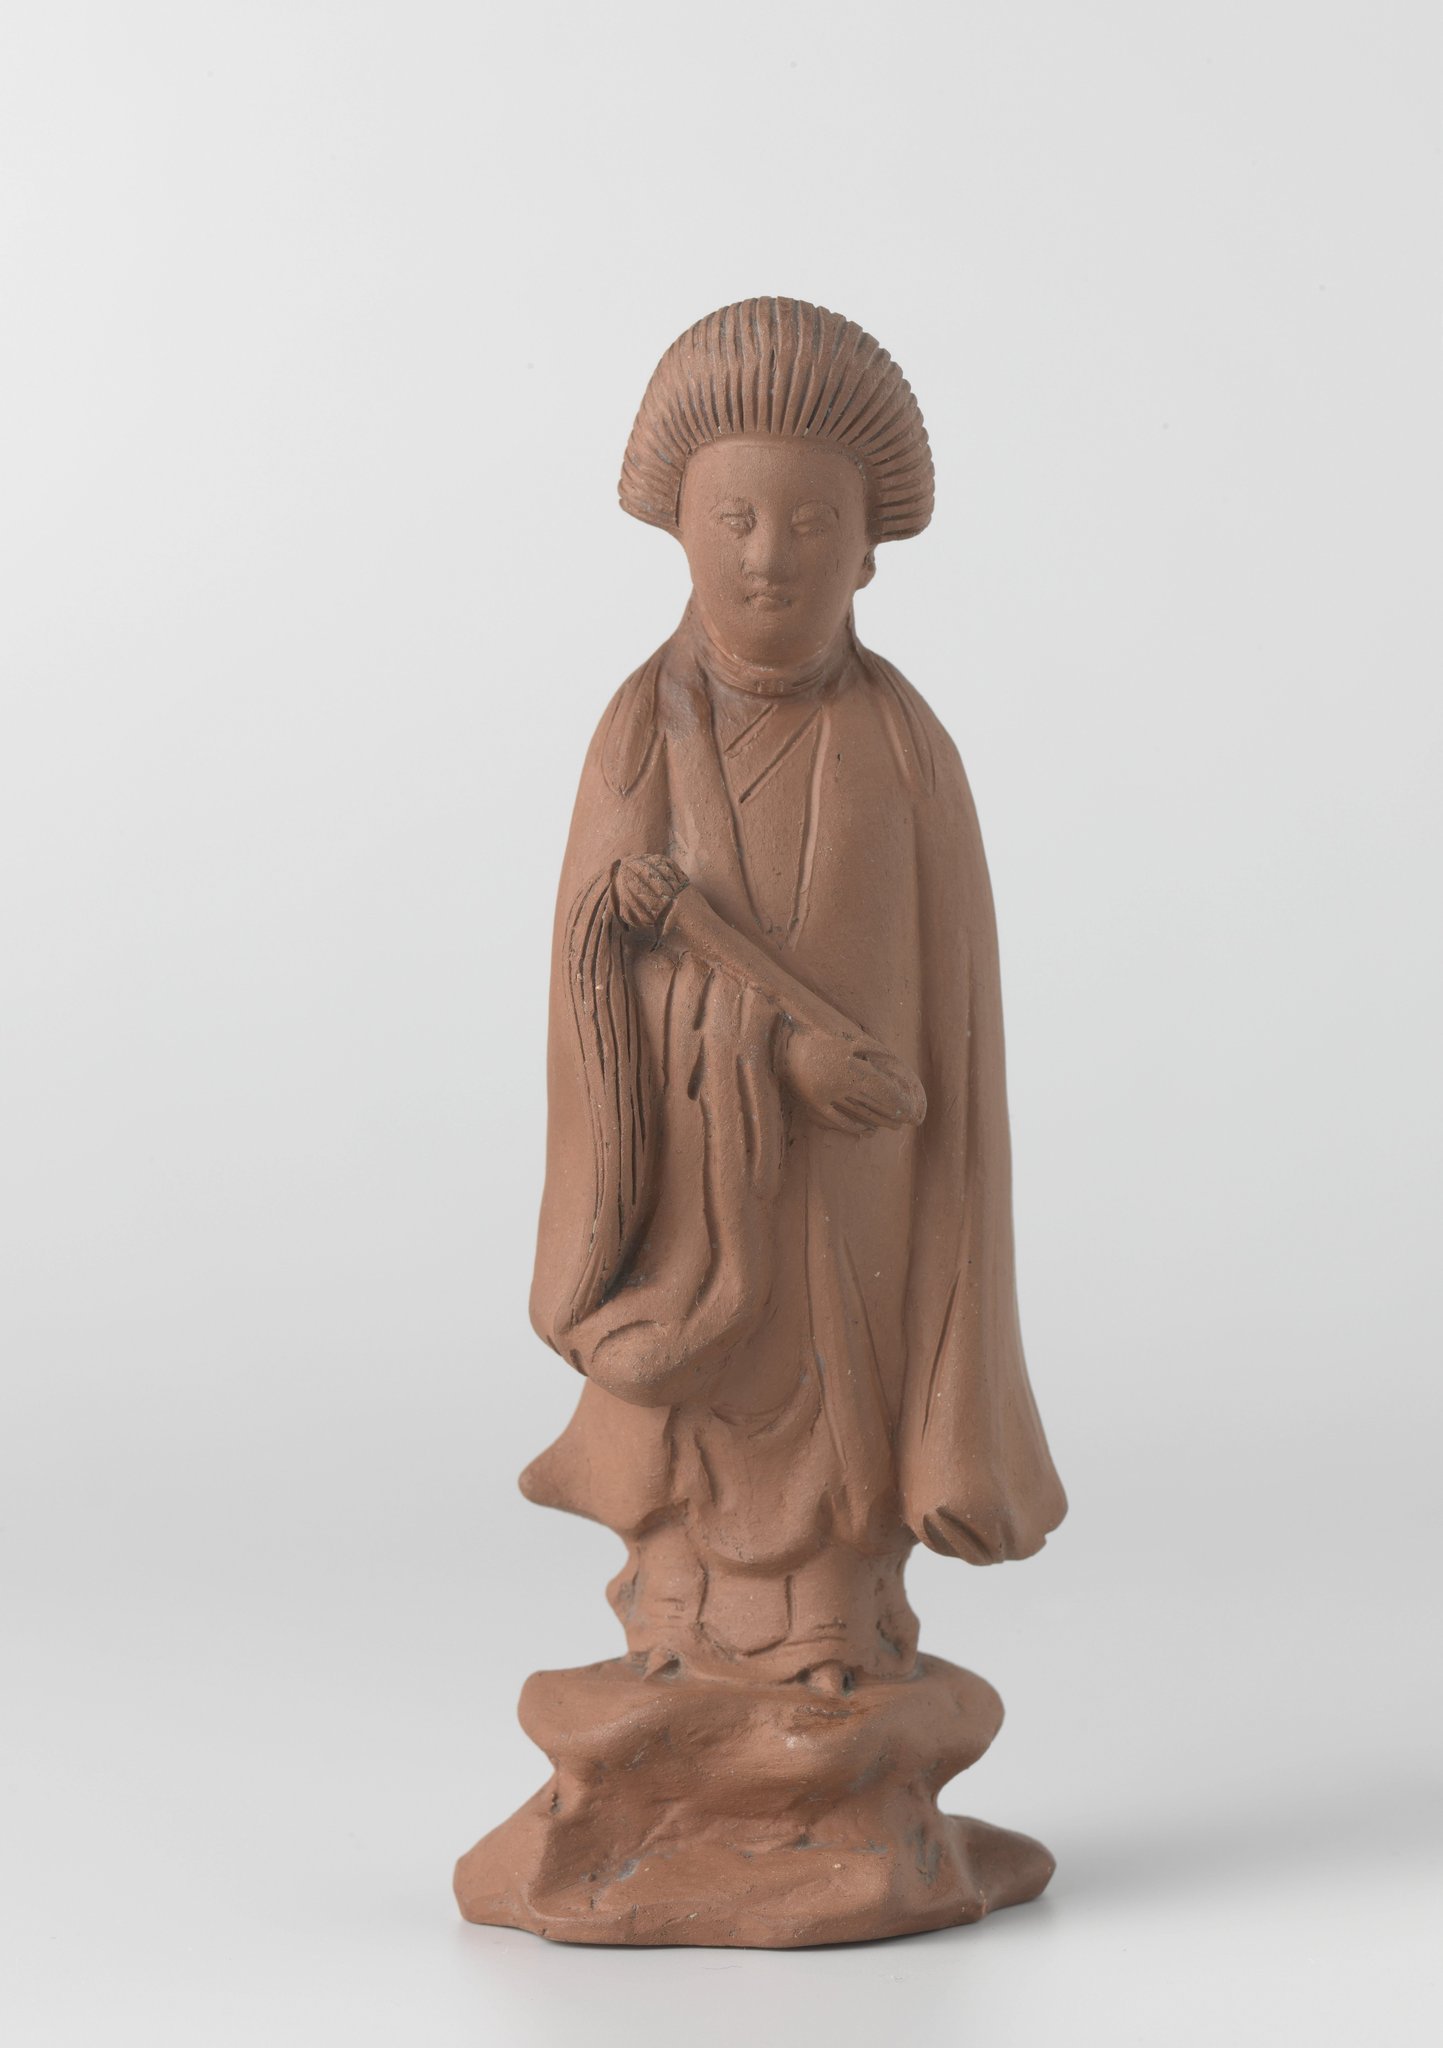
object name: decoratief object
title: Figurines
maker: Anonymous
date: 1680-1720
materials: earthenware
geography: delft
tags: guan yin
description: As examples for these figurines, Delft potters probably relied on traditional Chinese soapstone figurines, which first arrived in Europe in the late 17th century. The figure with the round face may be based on statues of the bodhisattva Guanyin, while the bearded man may have been inspired by figurines of Chinese scholars.